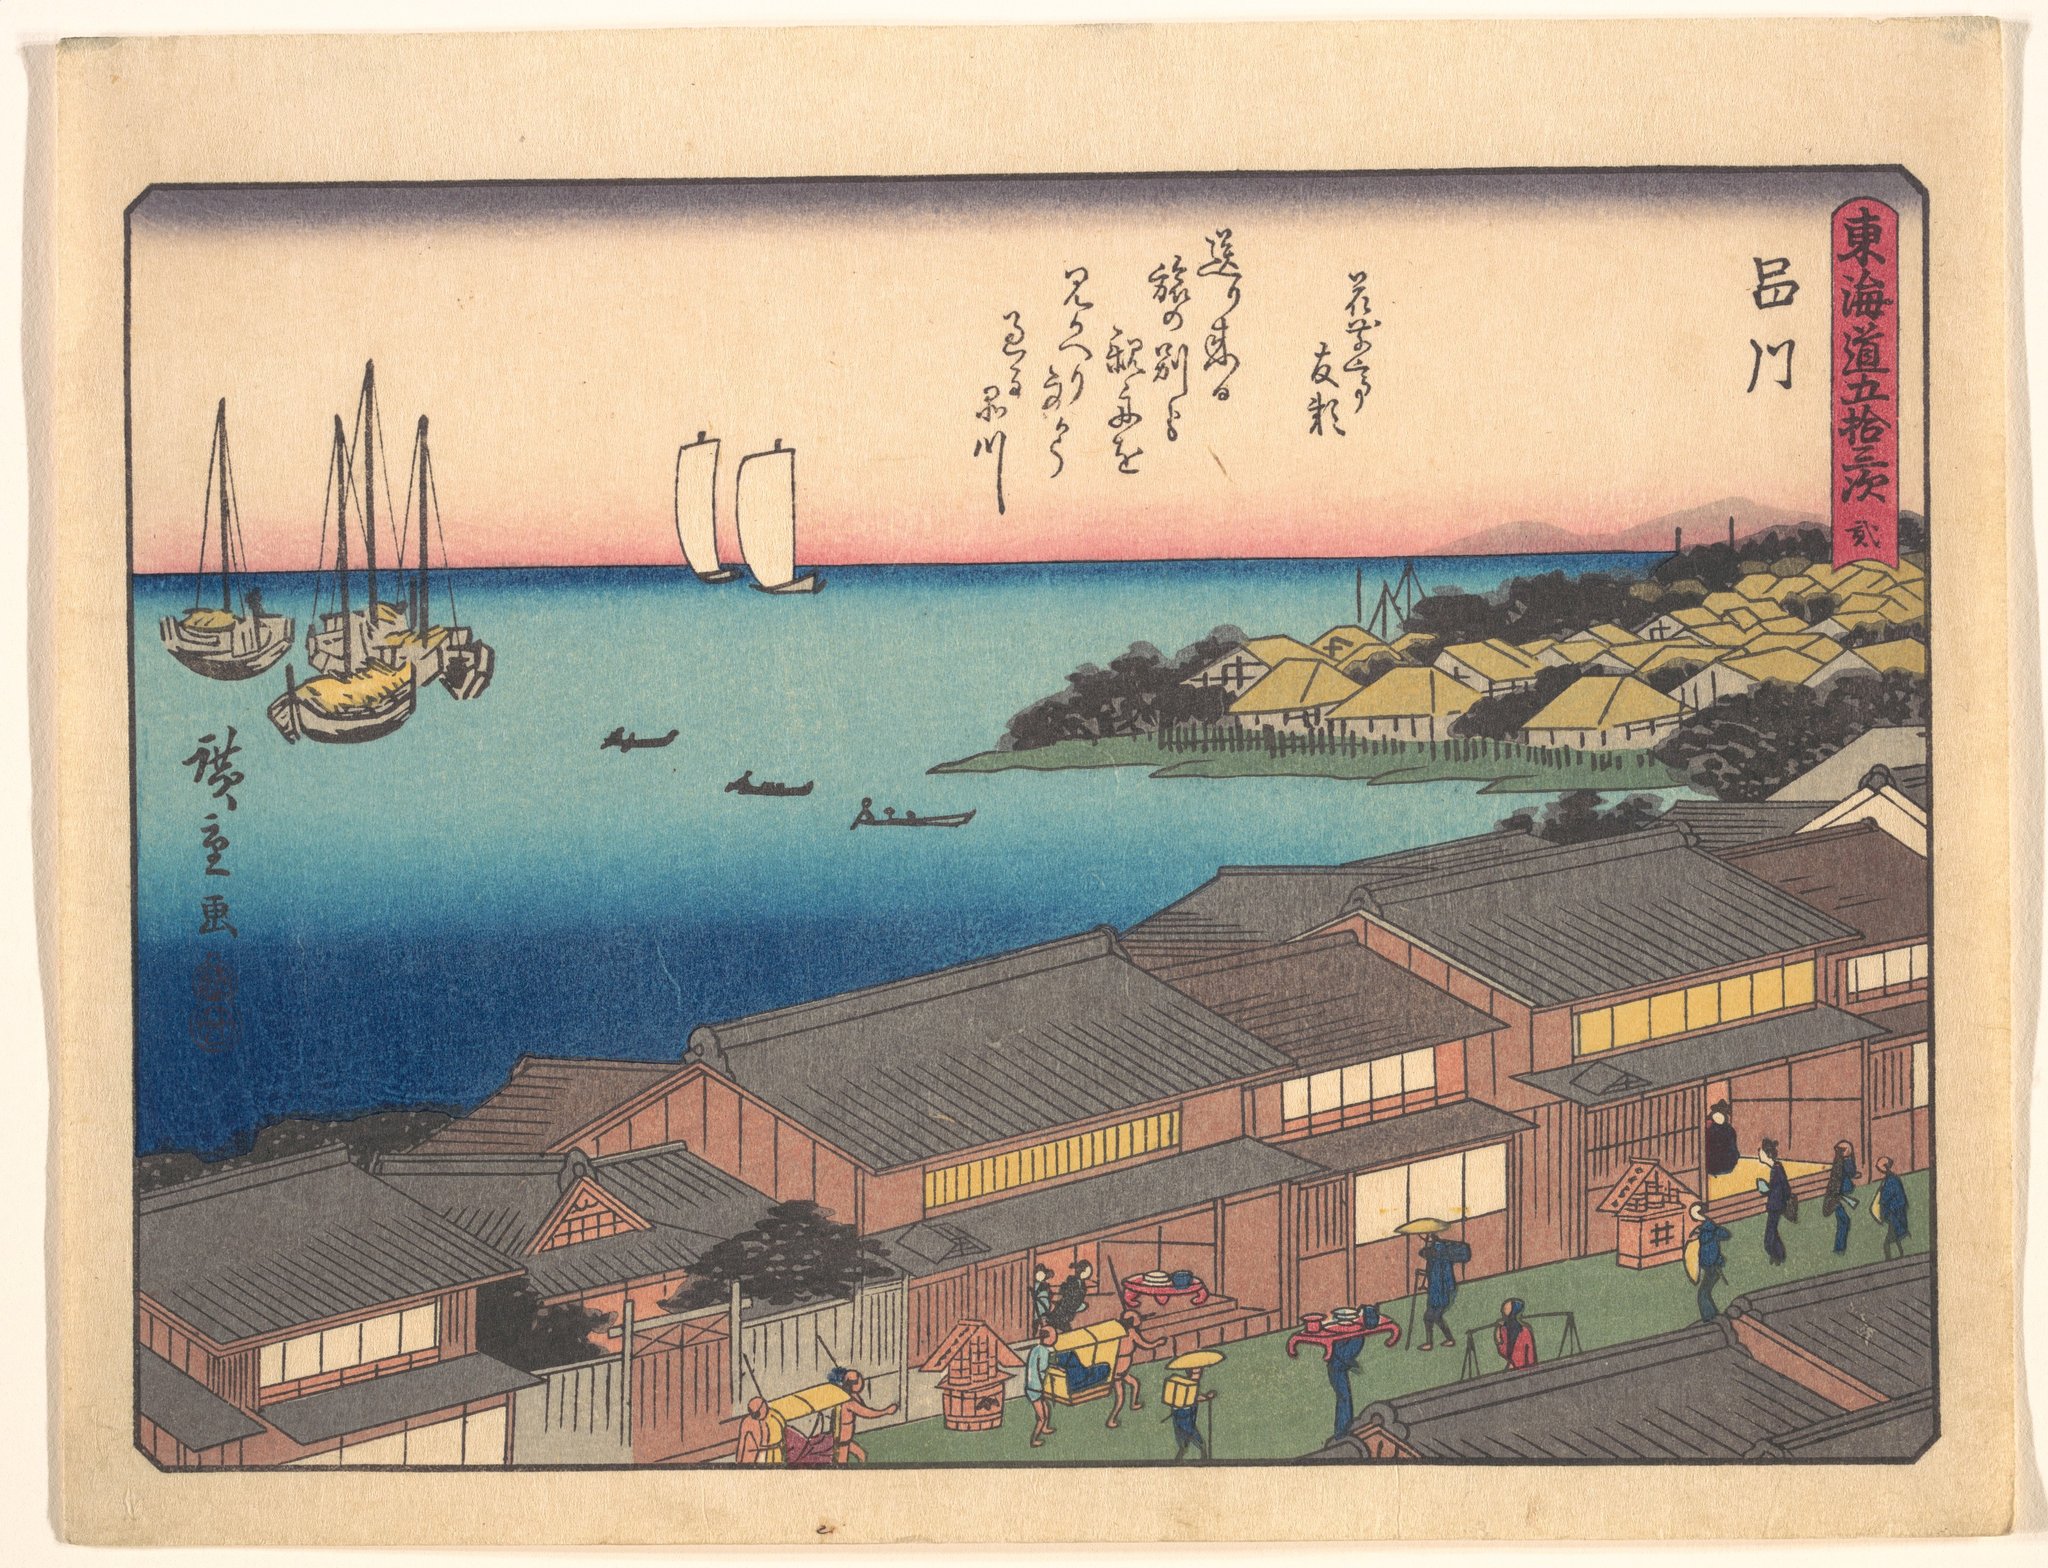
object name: print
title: 東海道五十三次 品川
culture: japanese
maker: utagawa hiroshige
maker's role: artist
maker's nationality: japanese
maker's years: 1797-1858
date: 1901-1933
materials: ink, paper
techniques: woodblock print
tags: human figures,houses,crowd,boats